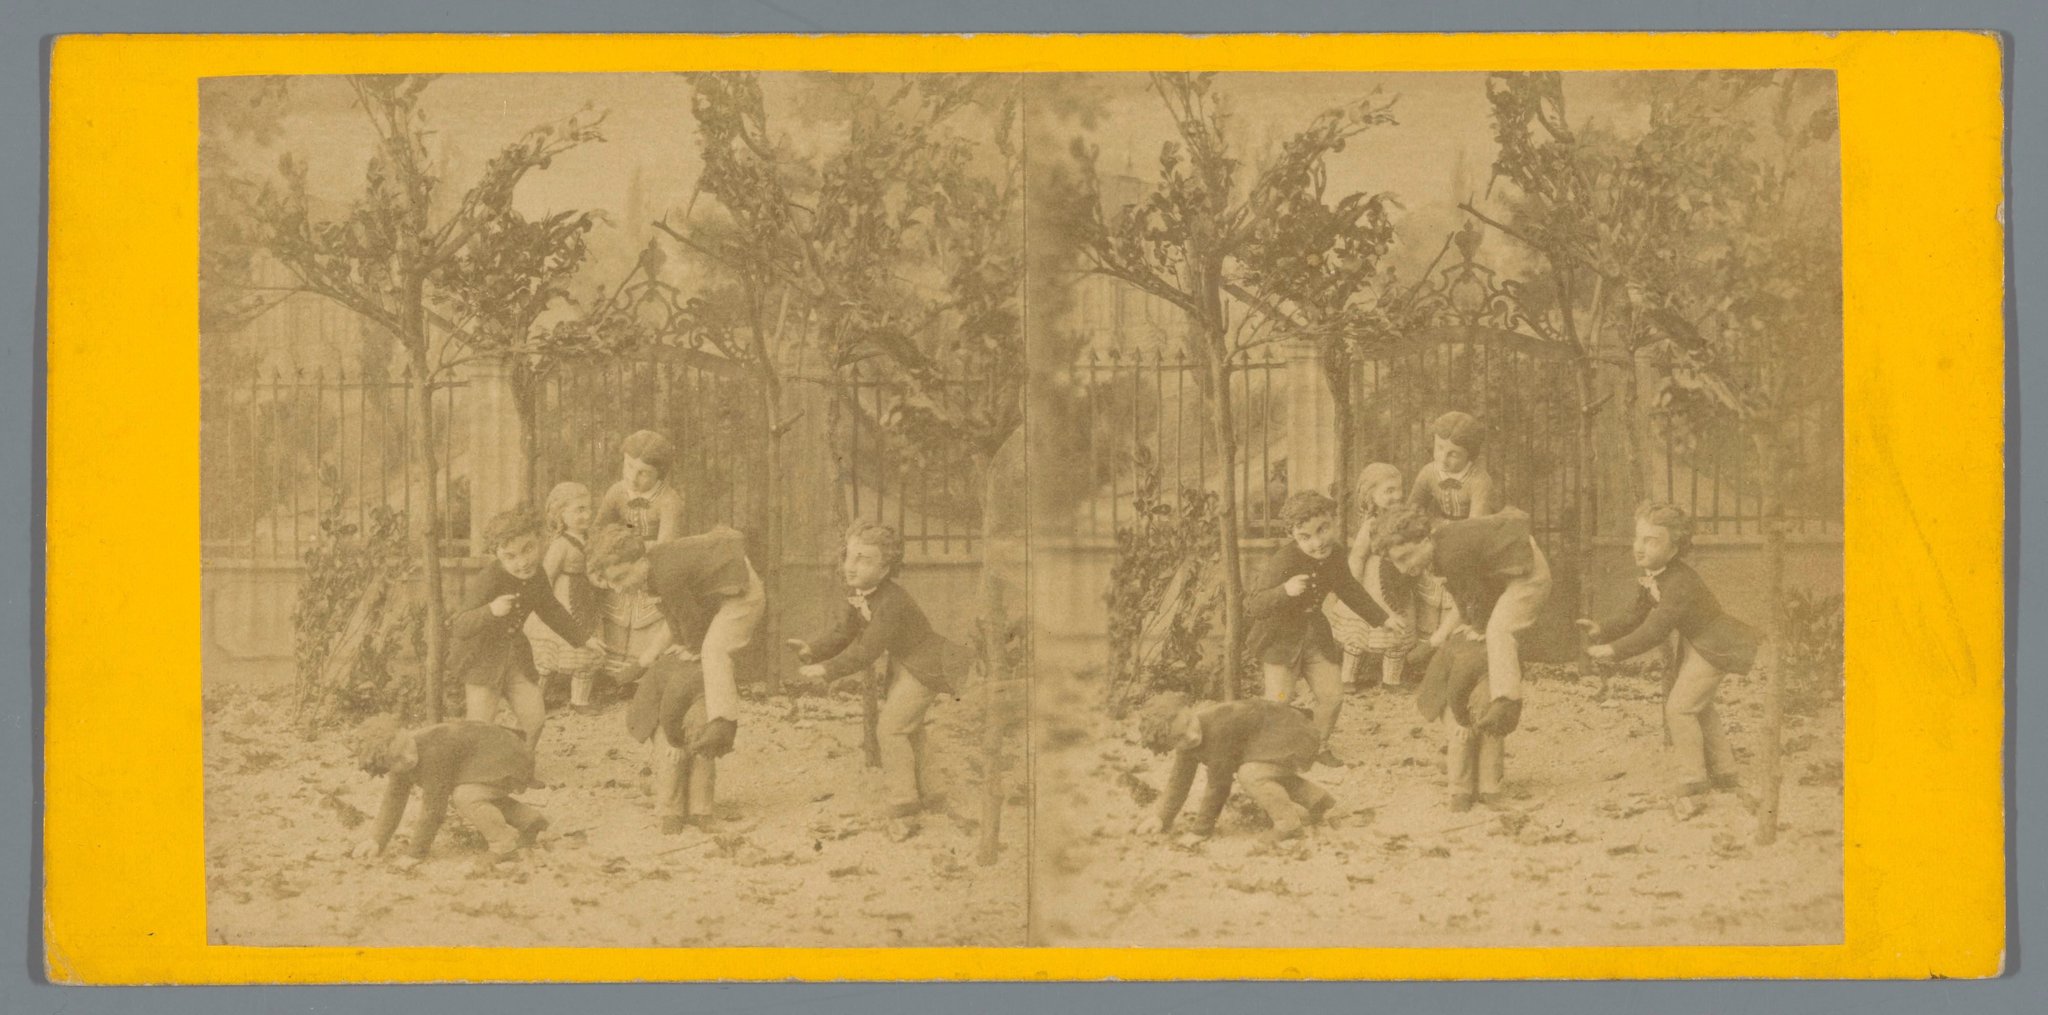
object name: stereograph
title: Enscenering van poppen in een decor, voorstellend jongens die haasje-over spelen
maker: Anonymous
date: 1850-1880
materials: cardboard, photographic support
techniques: albumen print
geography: europe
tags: jumping games, (playing with) dolls, europe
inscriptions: number: ‘10’